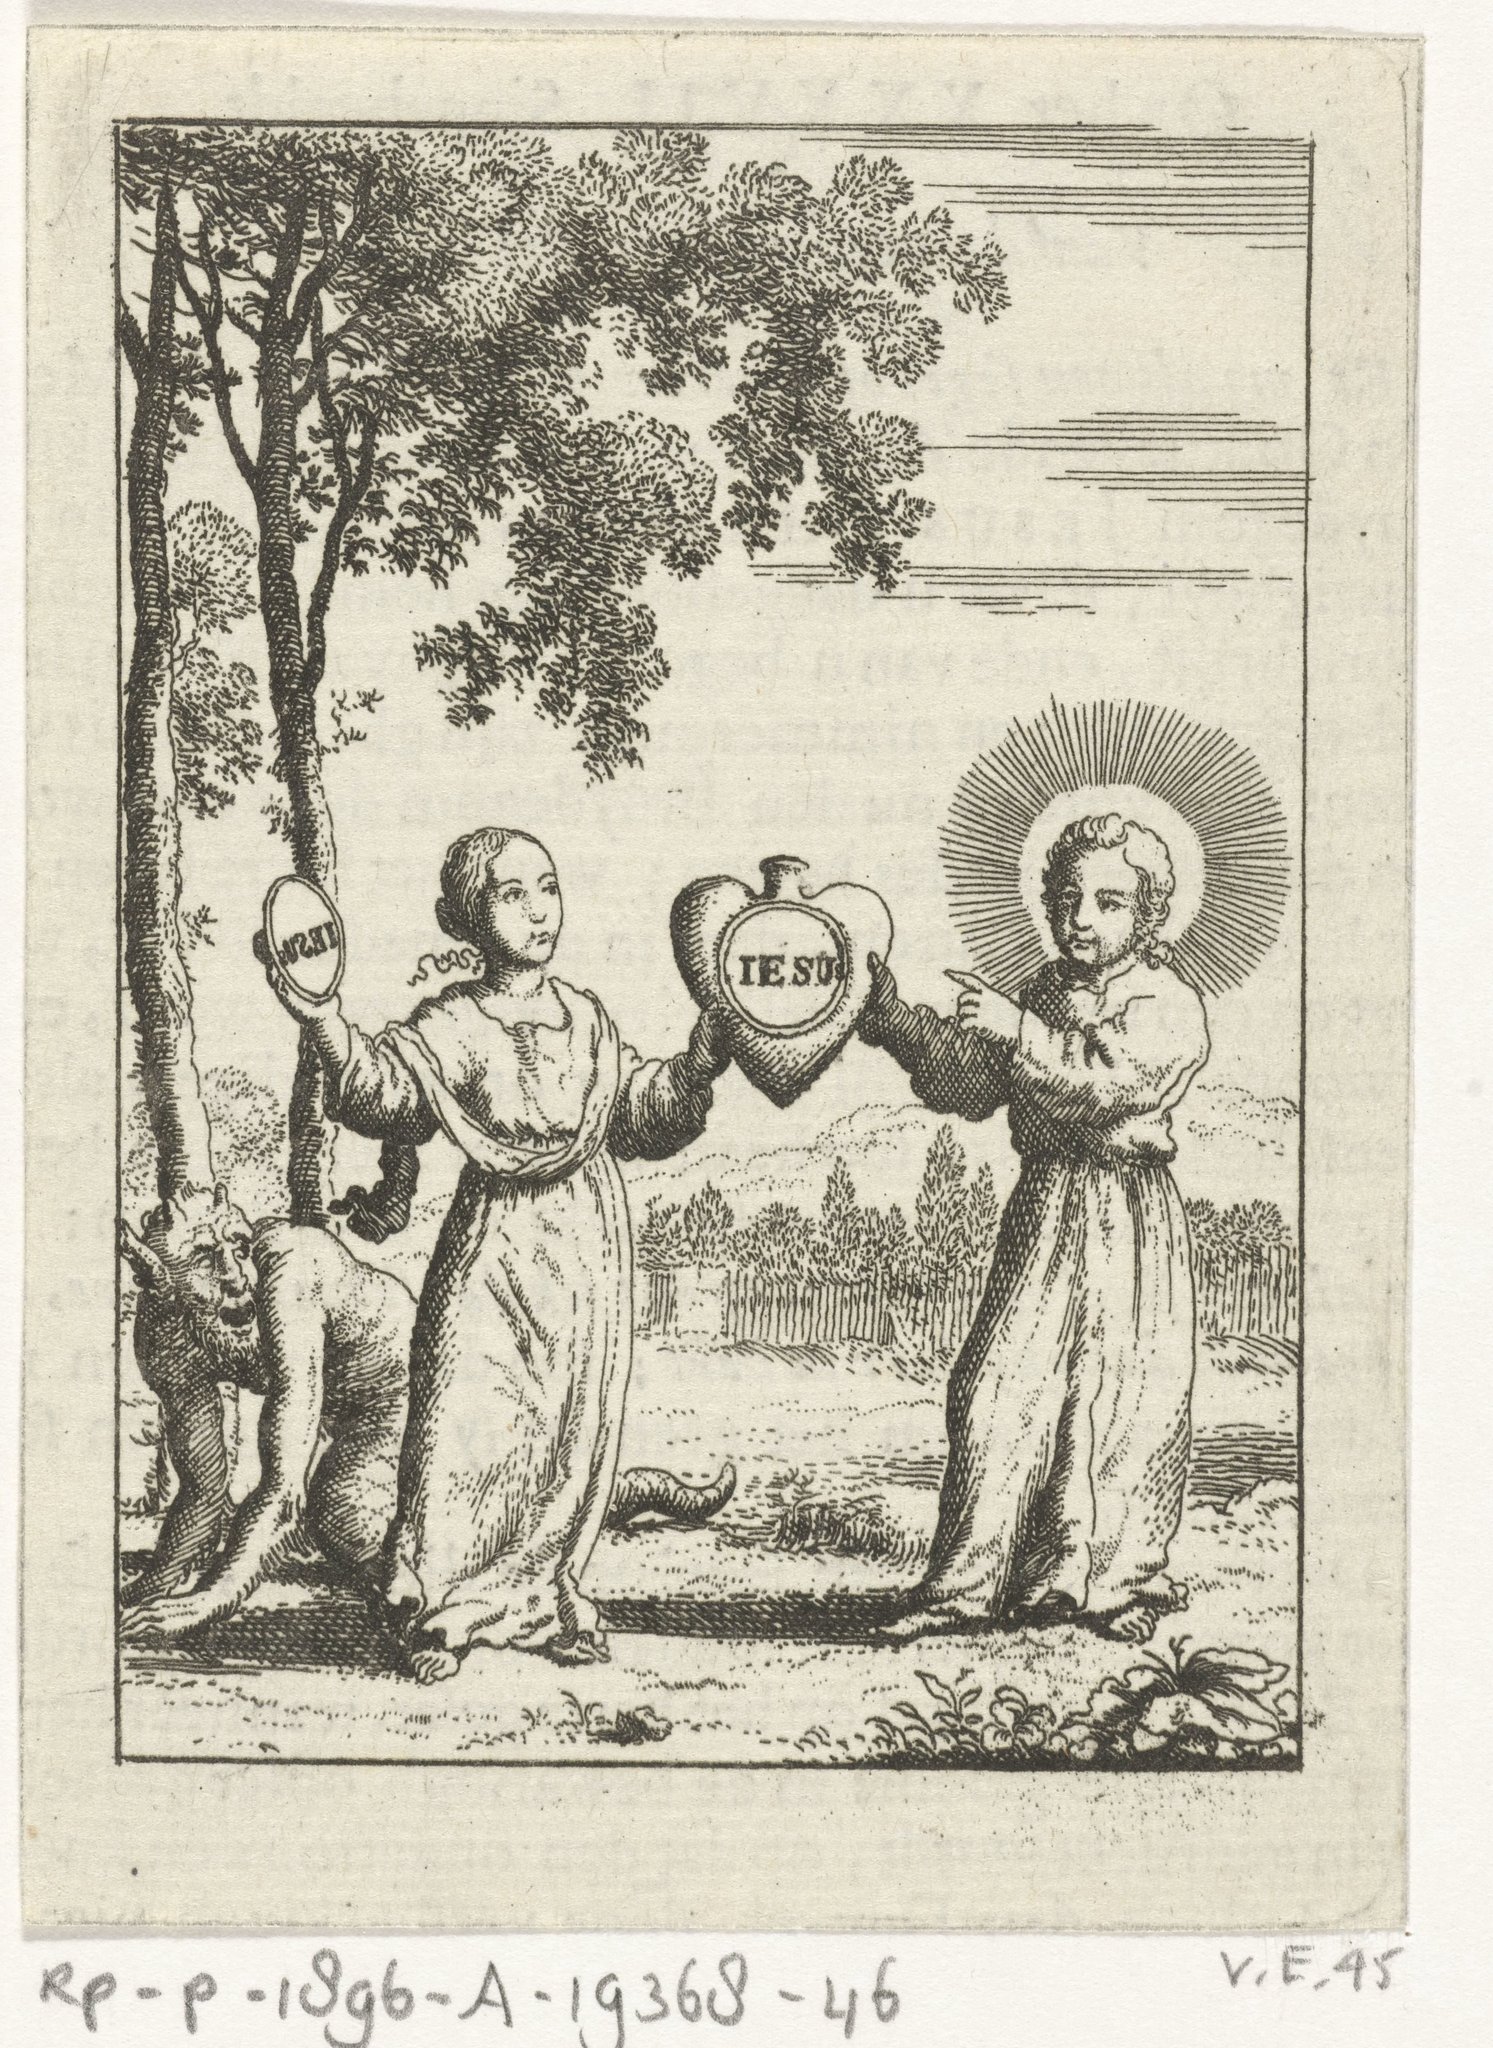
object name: print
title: Christus en de gepersonifieerde ziel houden samen een hart met de afdruk "Iesus" vast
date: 1678-1687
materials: paper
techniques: etching, letterpress printing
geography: amsterdam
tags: the soul, christ and the soul, christ and the human heart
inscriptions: collector's mark: Lugt 2228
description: Illustratie uit: Luyken, Jan. Jezus en de Ziel, 3 delen. Amsterdam: Pieter Arentsz II, 1678-1687. Tussen 1678-1744 verschenen van dit emblemataboek 10 edities.